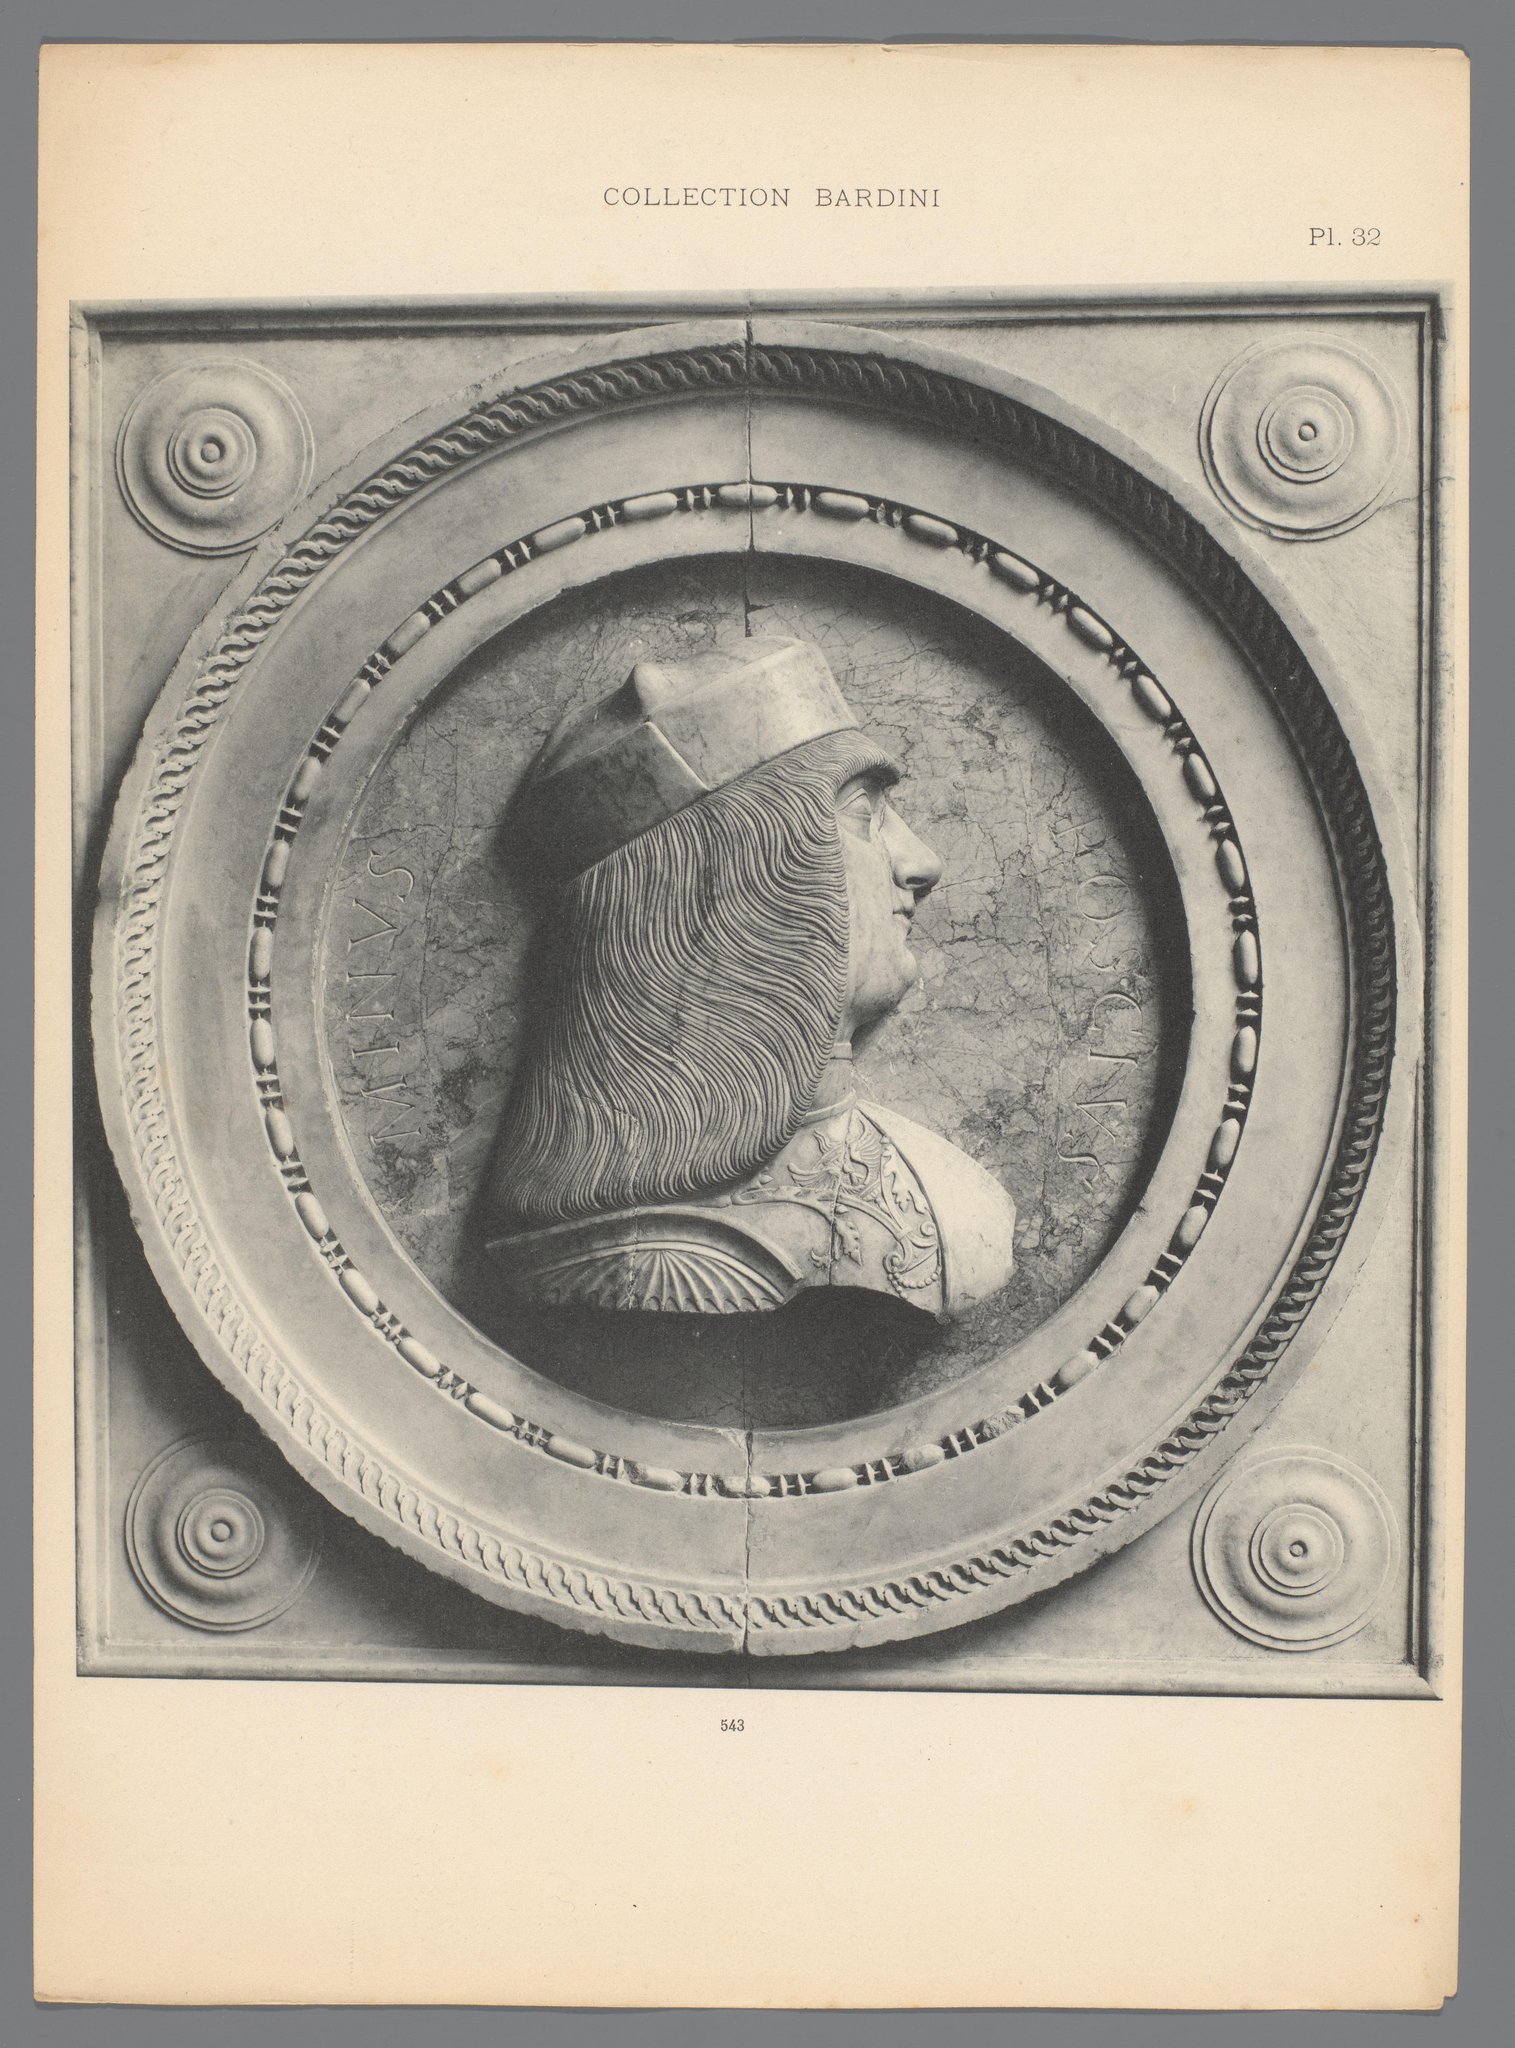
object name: photomechanical print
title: Reliëf van een onbekende man in een gedecoreerde cirkel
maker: Anonymous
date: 1875-1930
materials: paper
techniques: photograph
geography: florence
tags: anonymous historical person portrayed, sculpture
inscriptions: number: ‘Pl. 32’